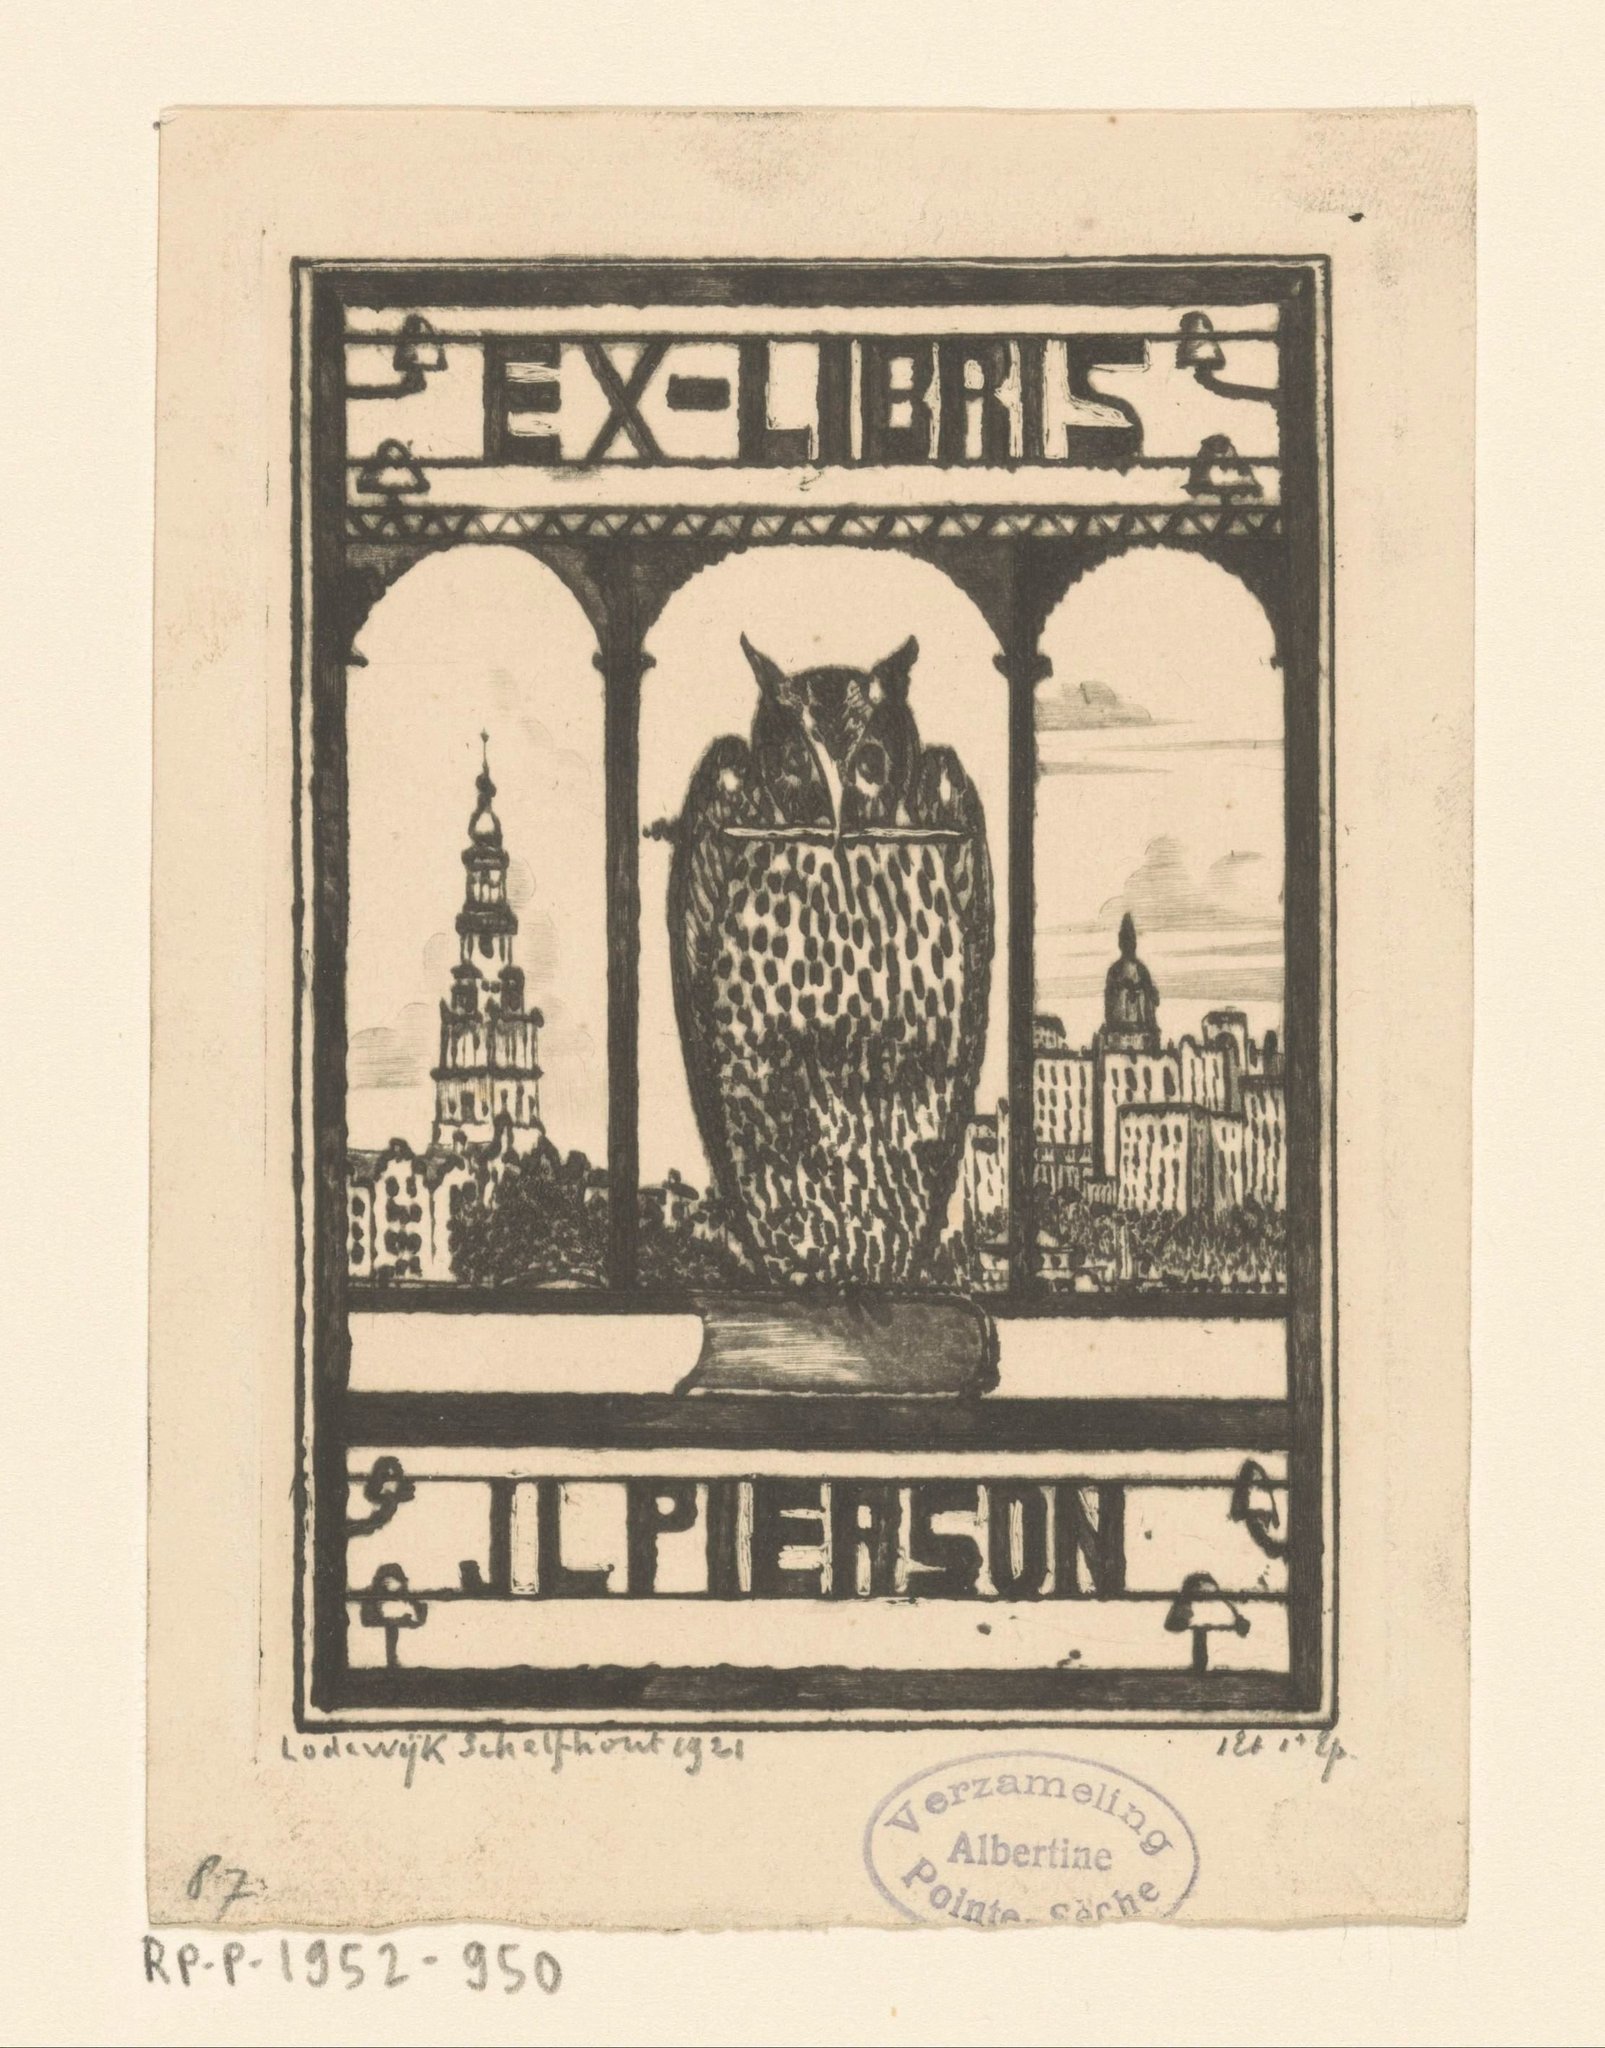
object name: print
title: Ex libris van J.L. Pierson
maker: lodewijk schelfhout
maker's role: draughtsman, print maker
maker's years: 1881-1943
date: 1921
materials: paper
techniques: drypoint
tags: view through a window, pen, book, owls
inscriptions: collector's mark: Lugt 2228, collector's mark: Lugt 5i, collector's mark: Lugt 2760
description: Een uil met een pen in zijn snavel, zittend op een boek. Op de achtergrond zicht op een stad door drie boogvensters.